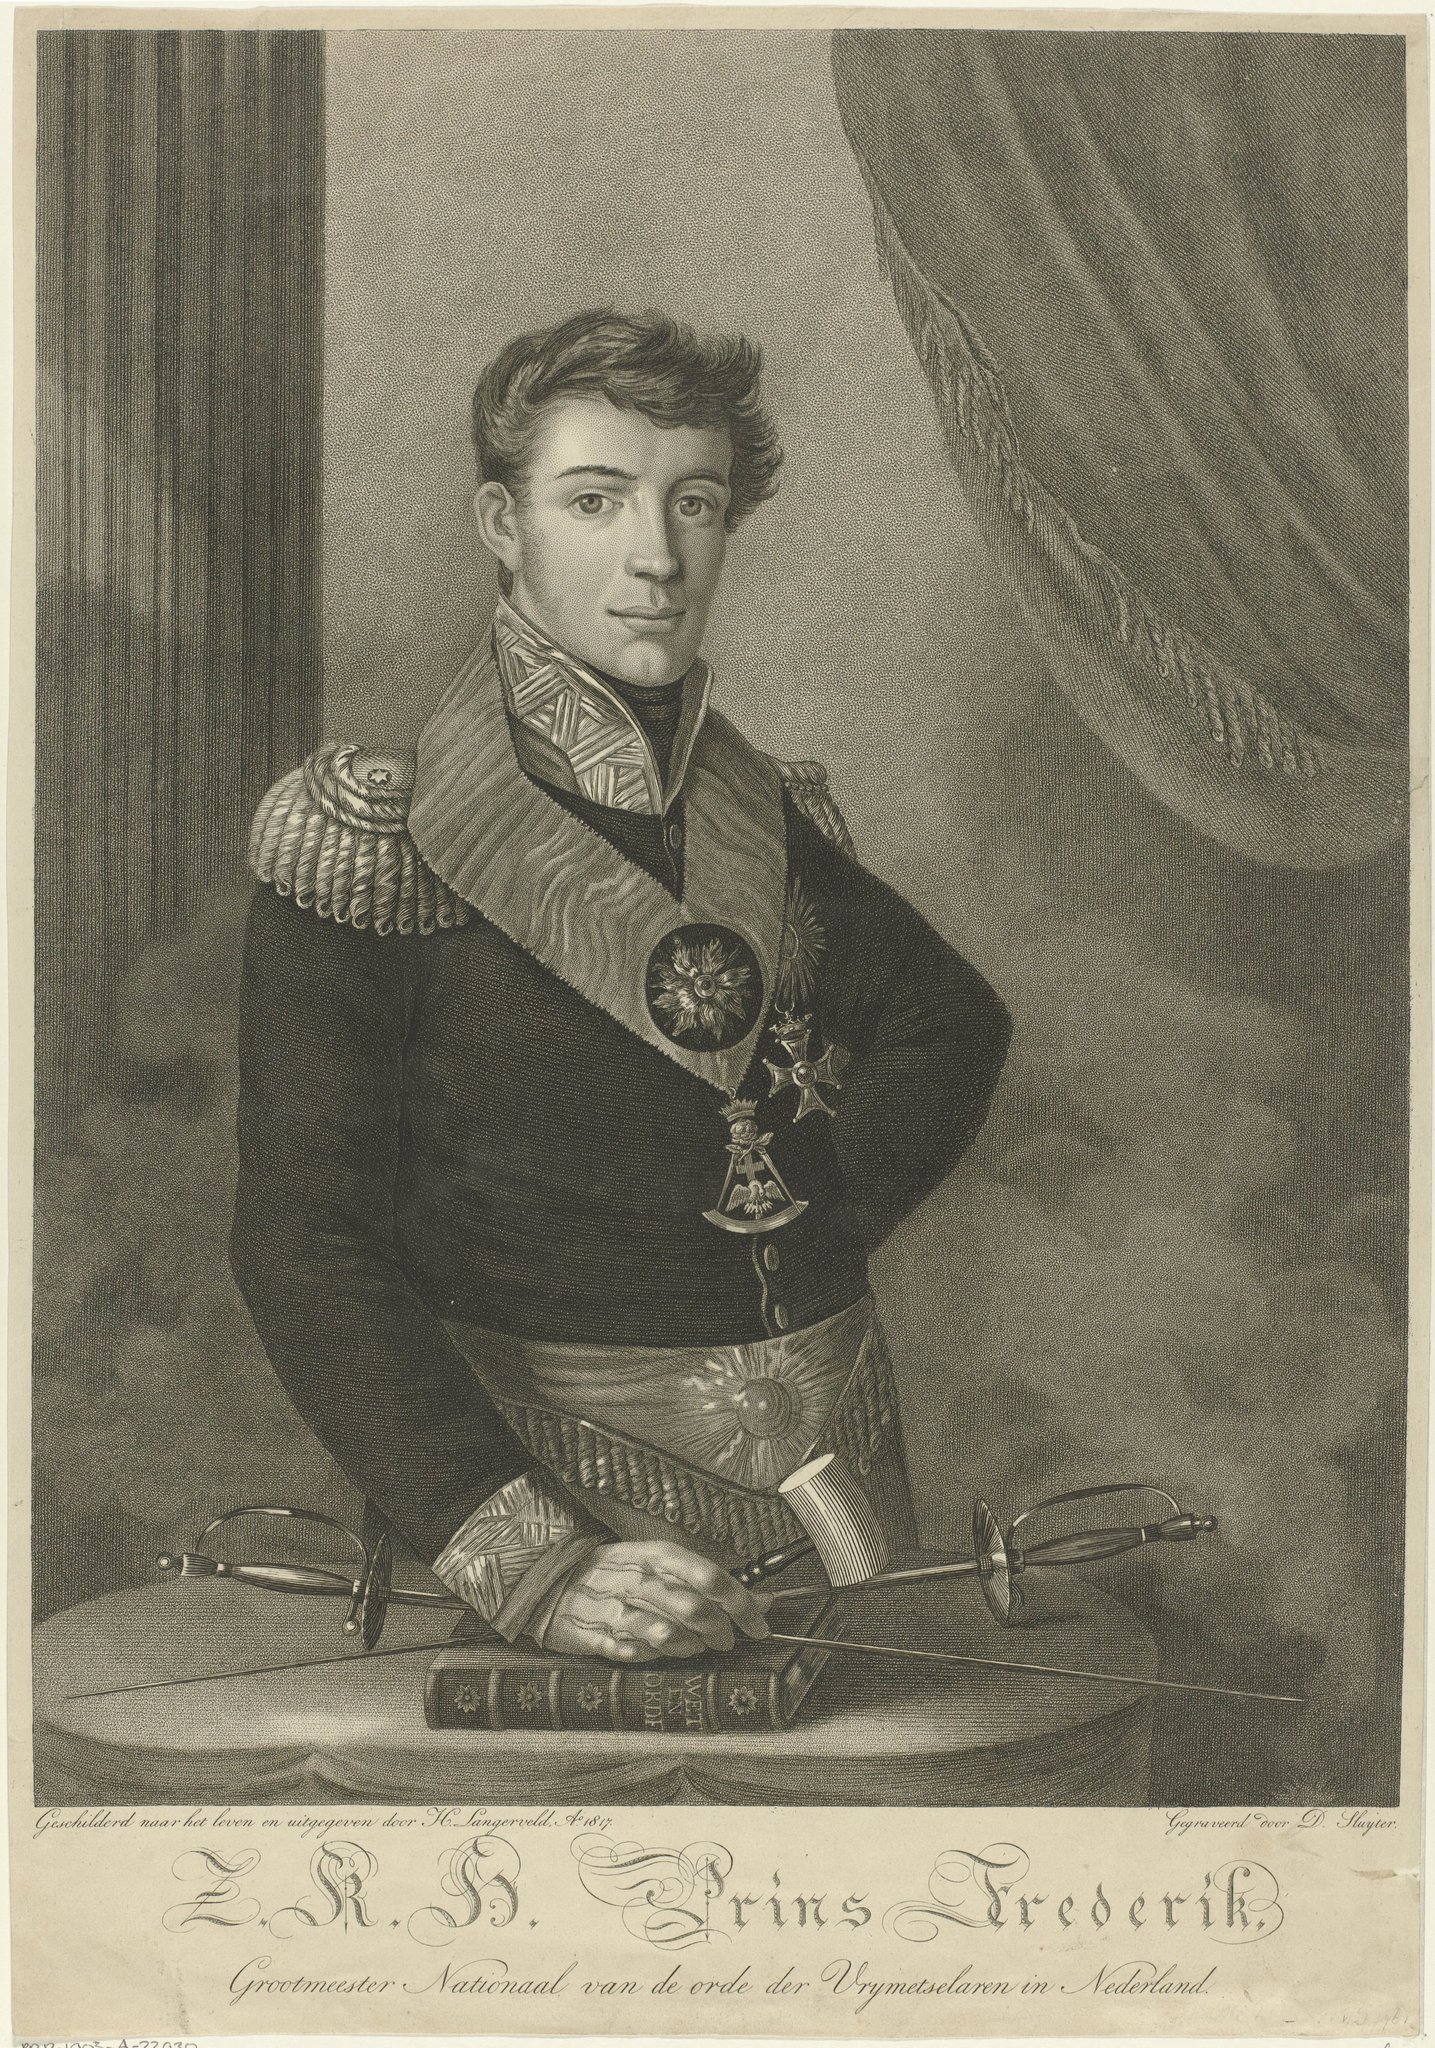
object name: print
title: Portret van Frederik, prins der Nederlanden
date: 1817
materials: paper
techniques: engraving, etching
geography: amsterdam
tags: frederik (prins der nederlanden)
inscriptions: collector's mark: Lugt 2166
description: Portret van Frederik als grootmeester der Vrijmetselaren. In zijn rechterhand een hamer. Daaronder ligt een boek met twee gekruiste degens. In de ondermarge zijn naam en titels.